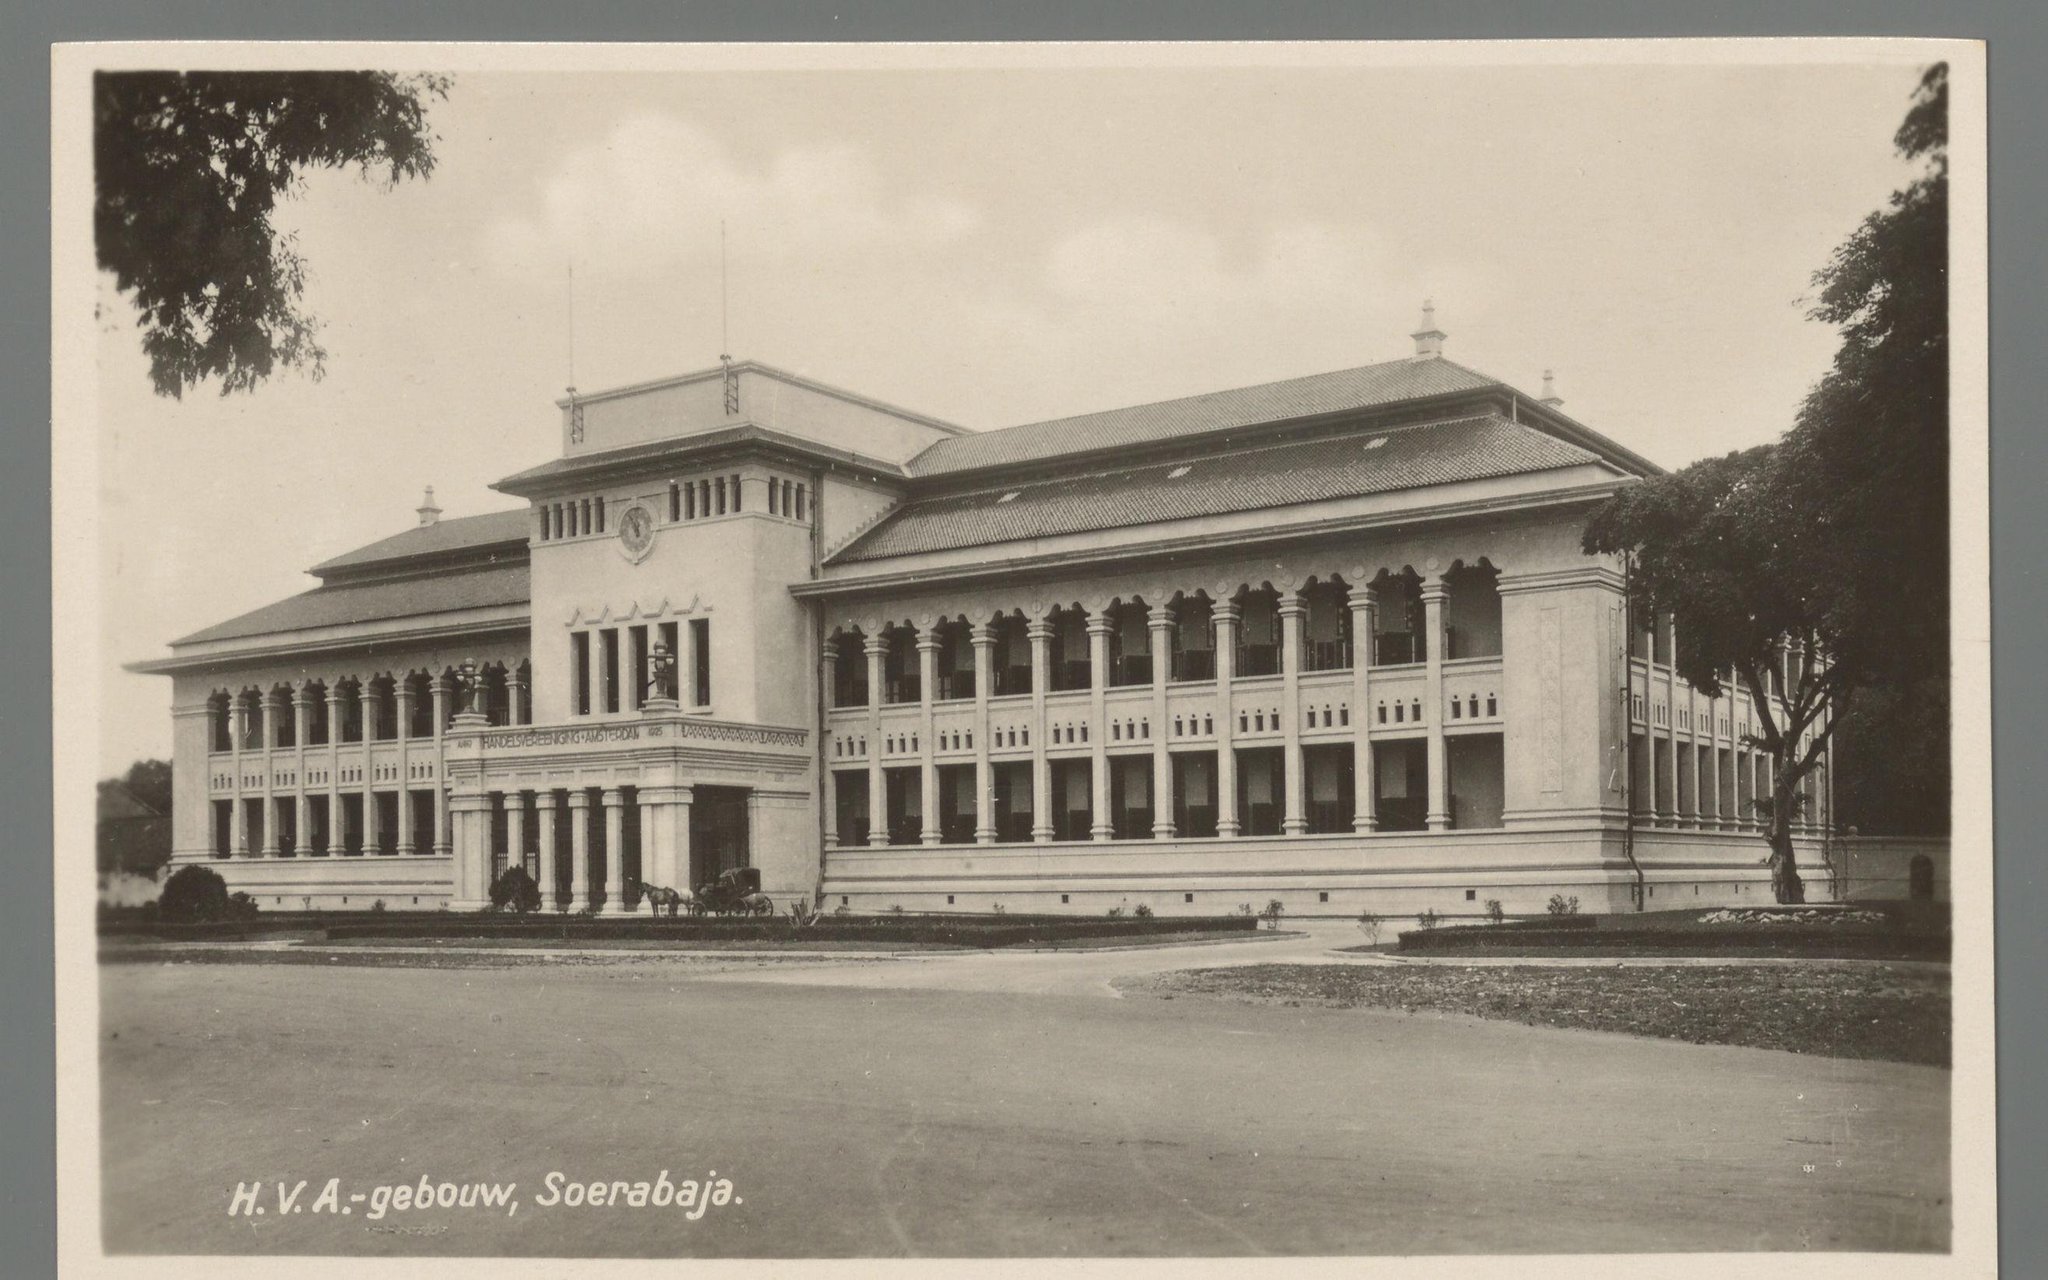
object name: ansichtkaart, prentbriefkaart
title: H.V.A.-gebouw, Soerabaja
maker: Anonymous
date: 1919-1930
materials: paper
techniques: gelatin silver print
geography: surabaya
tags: edifice, e.g.: public building, department store, surabaya